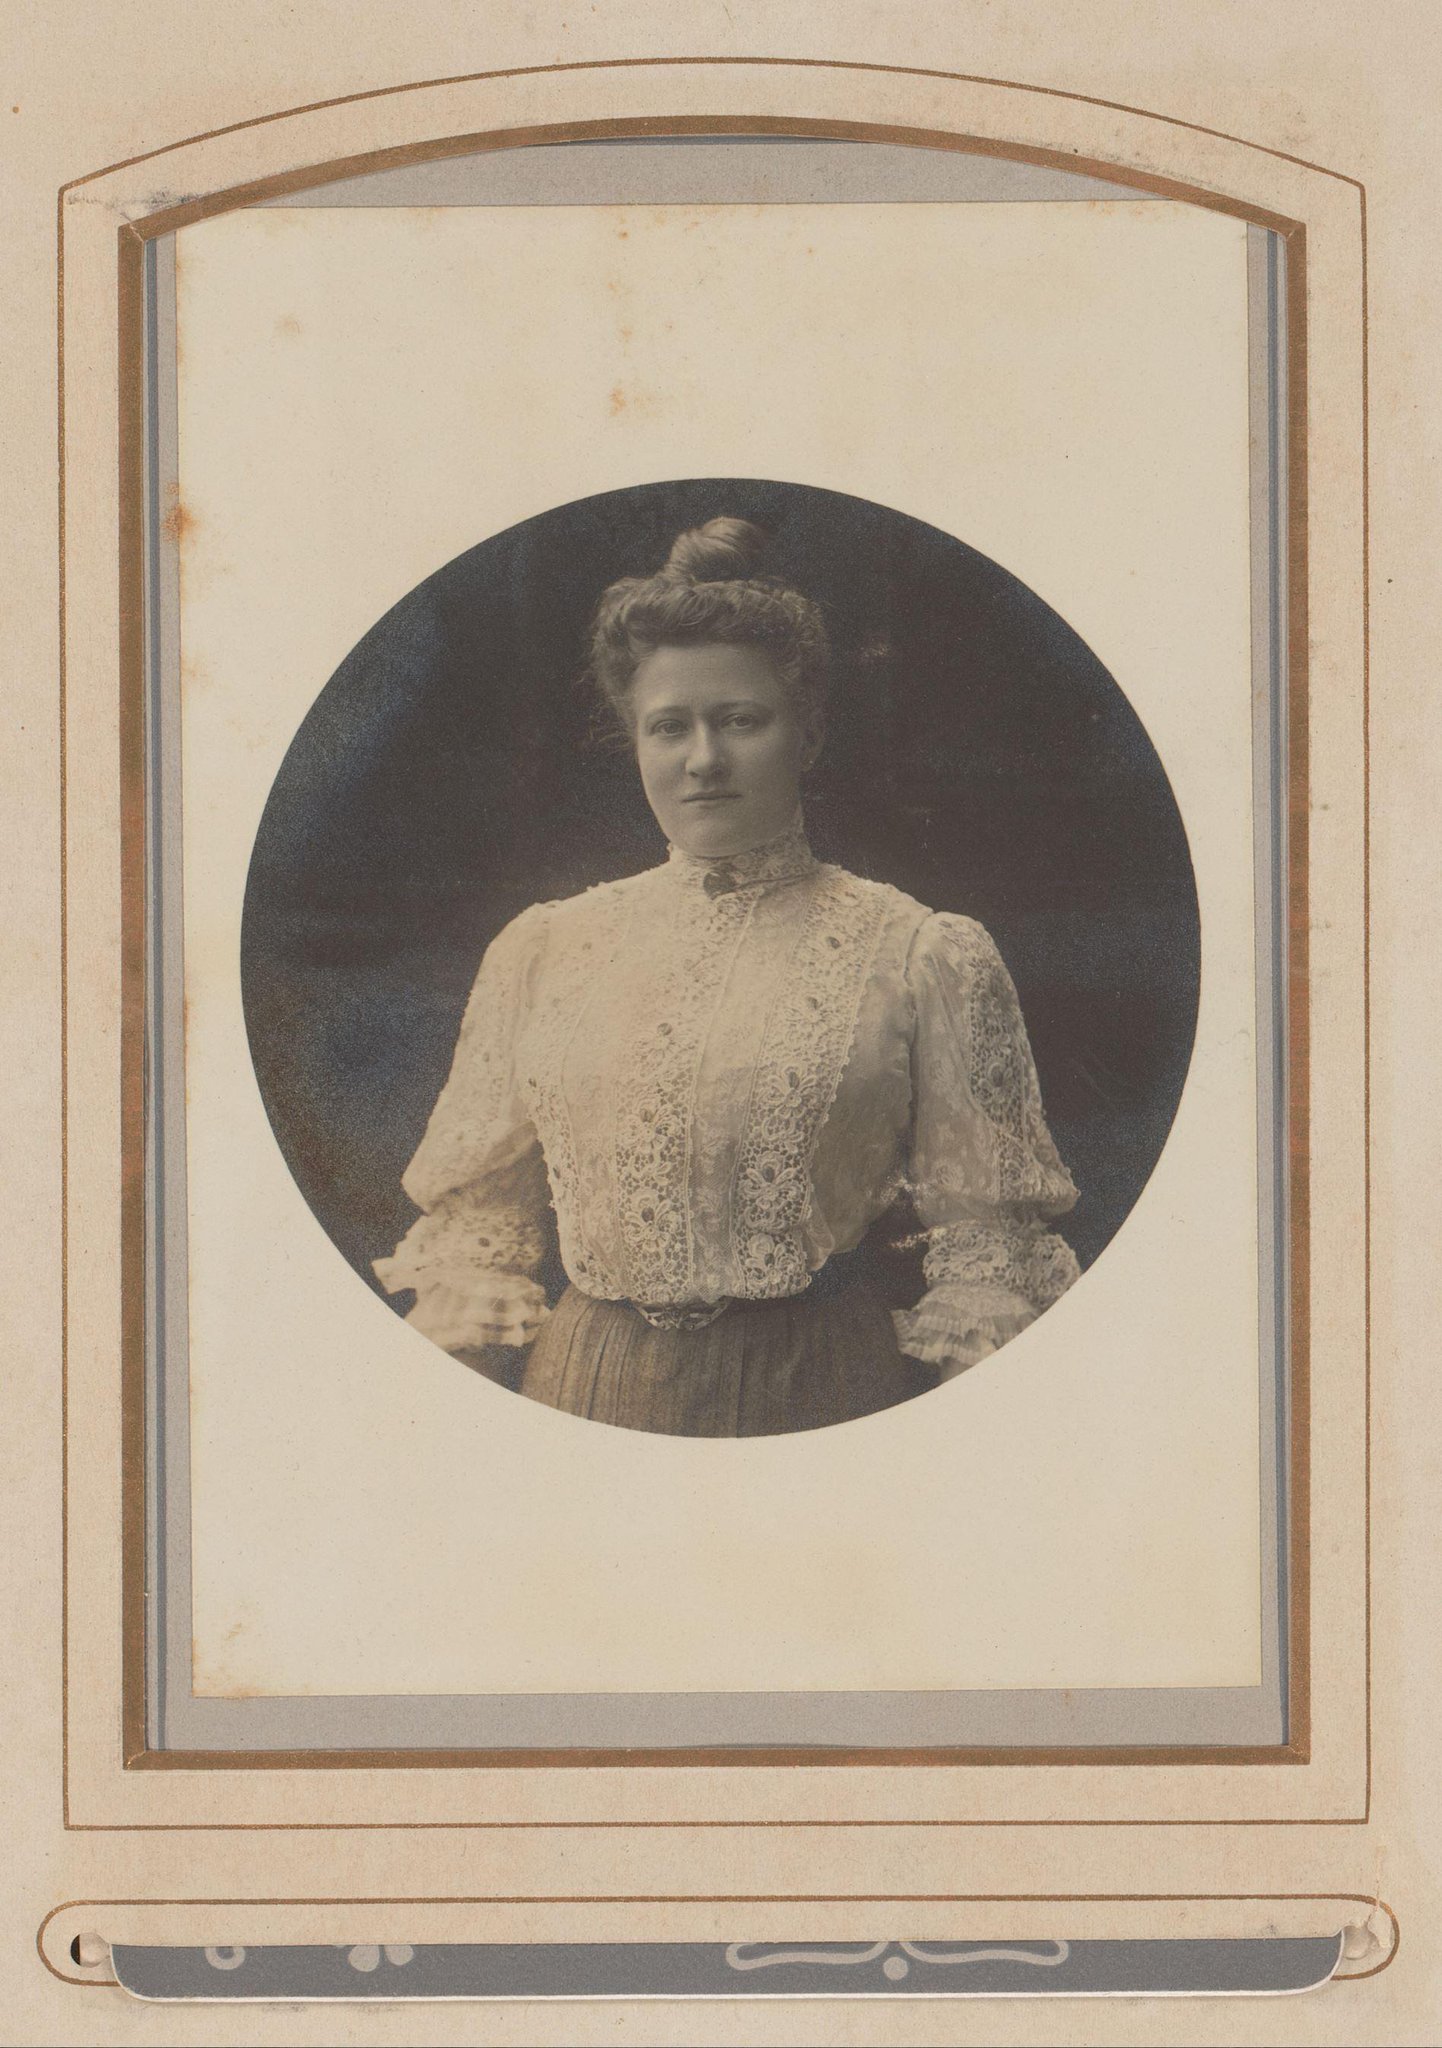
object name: photograph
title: Portret van een jonge vrouw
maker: Anonymous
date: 1900-1930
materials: cardboard, photographic support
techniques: gelatin silver print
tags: adolescent, young woman, maiden, historical persons - bb - woman